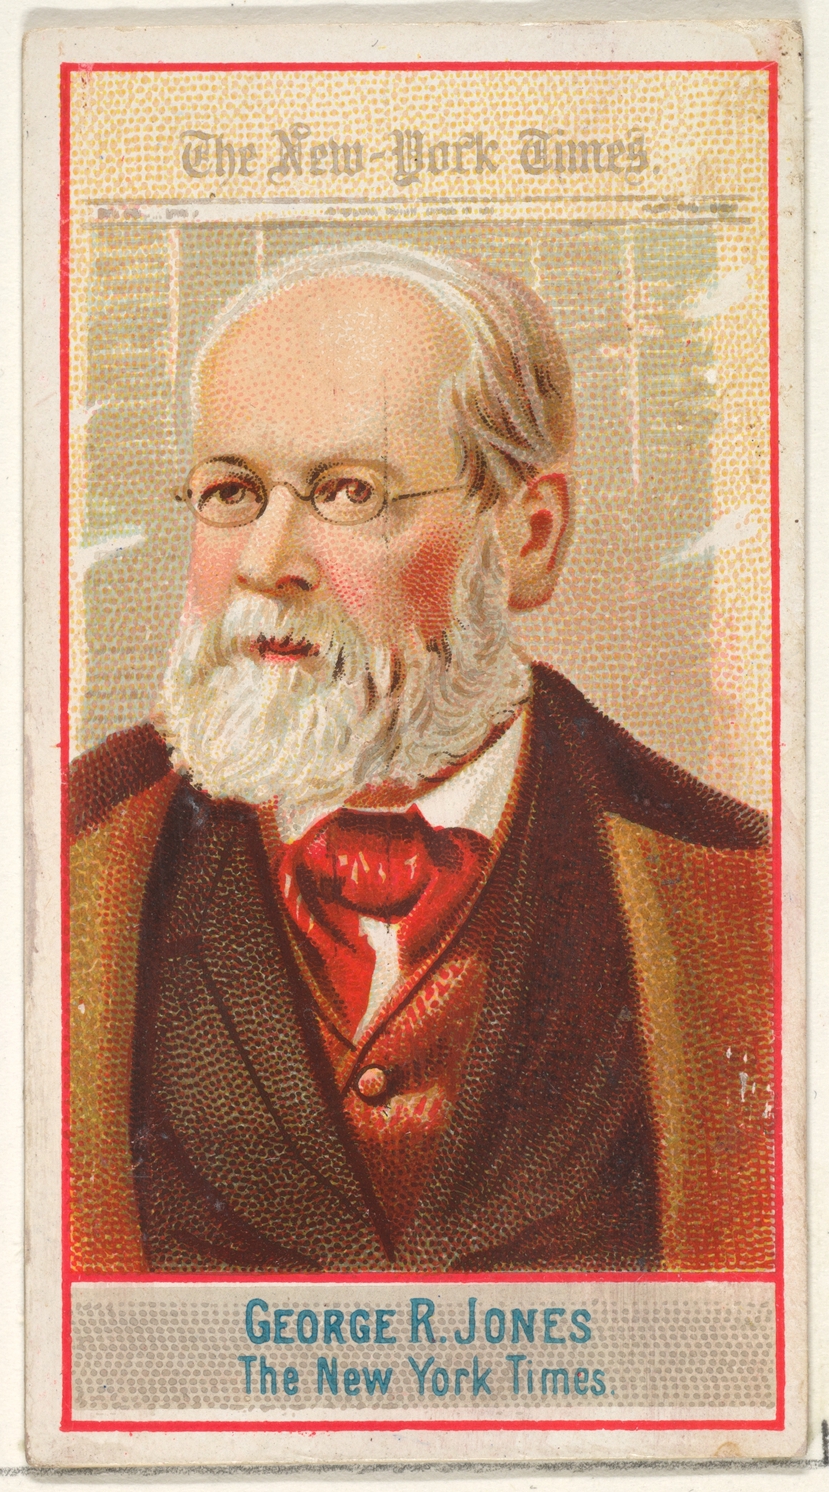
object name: print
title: George R. Jones, The New York Times, from the American Editors series (N1) for Allen & Ginter Cigarettes Brands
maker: allen & ginter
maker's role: publisher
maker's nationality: american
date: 1887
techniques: color lithograph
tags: men,portraits